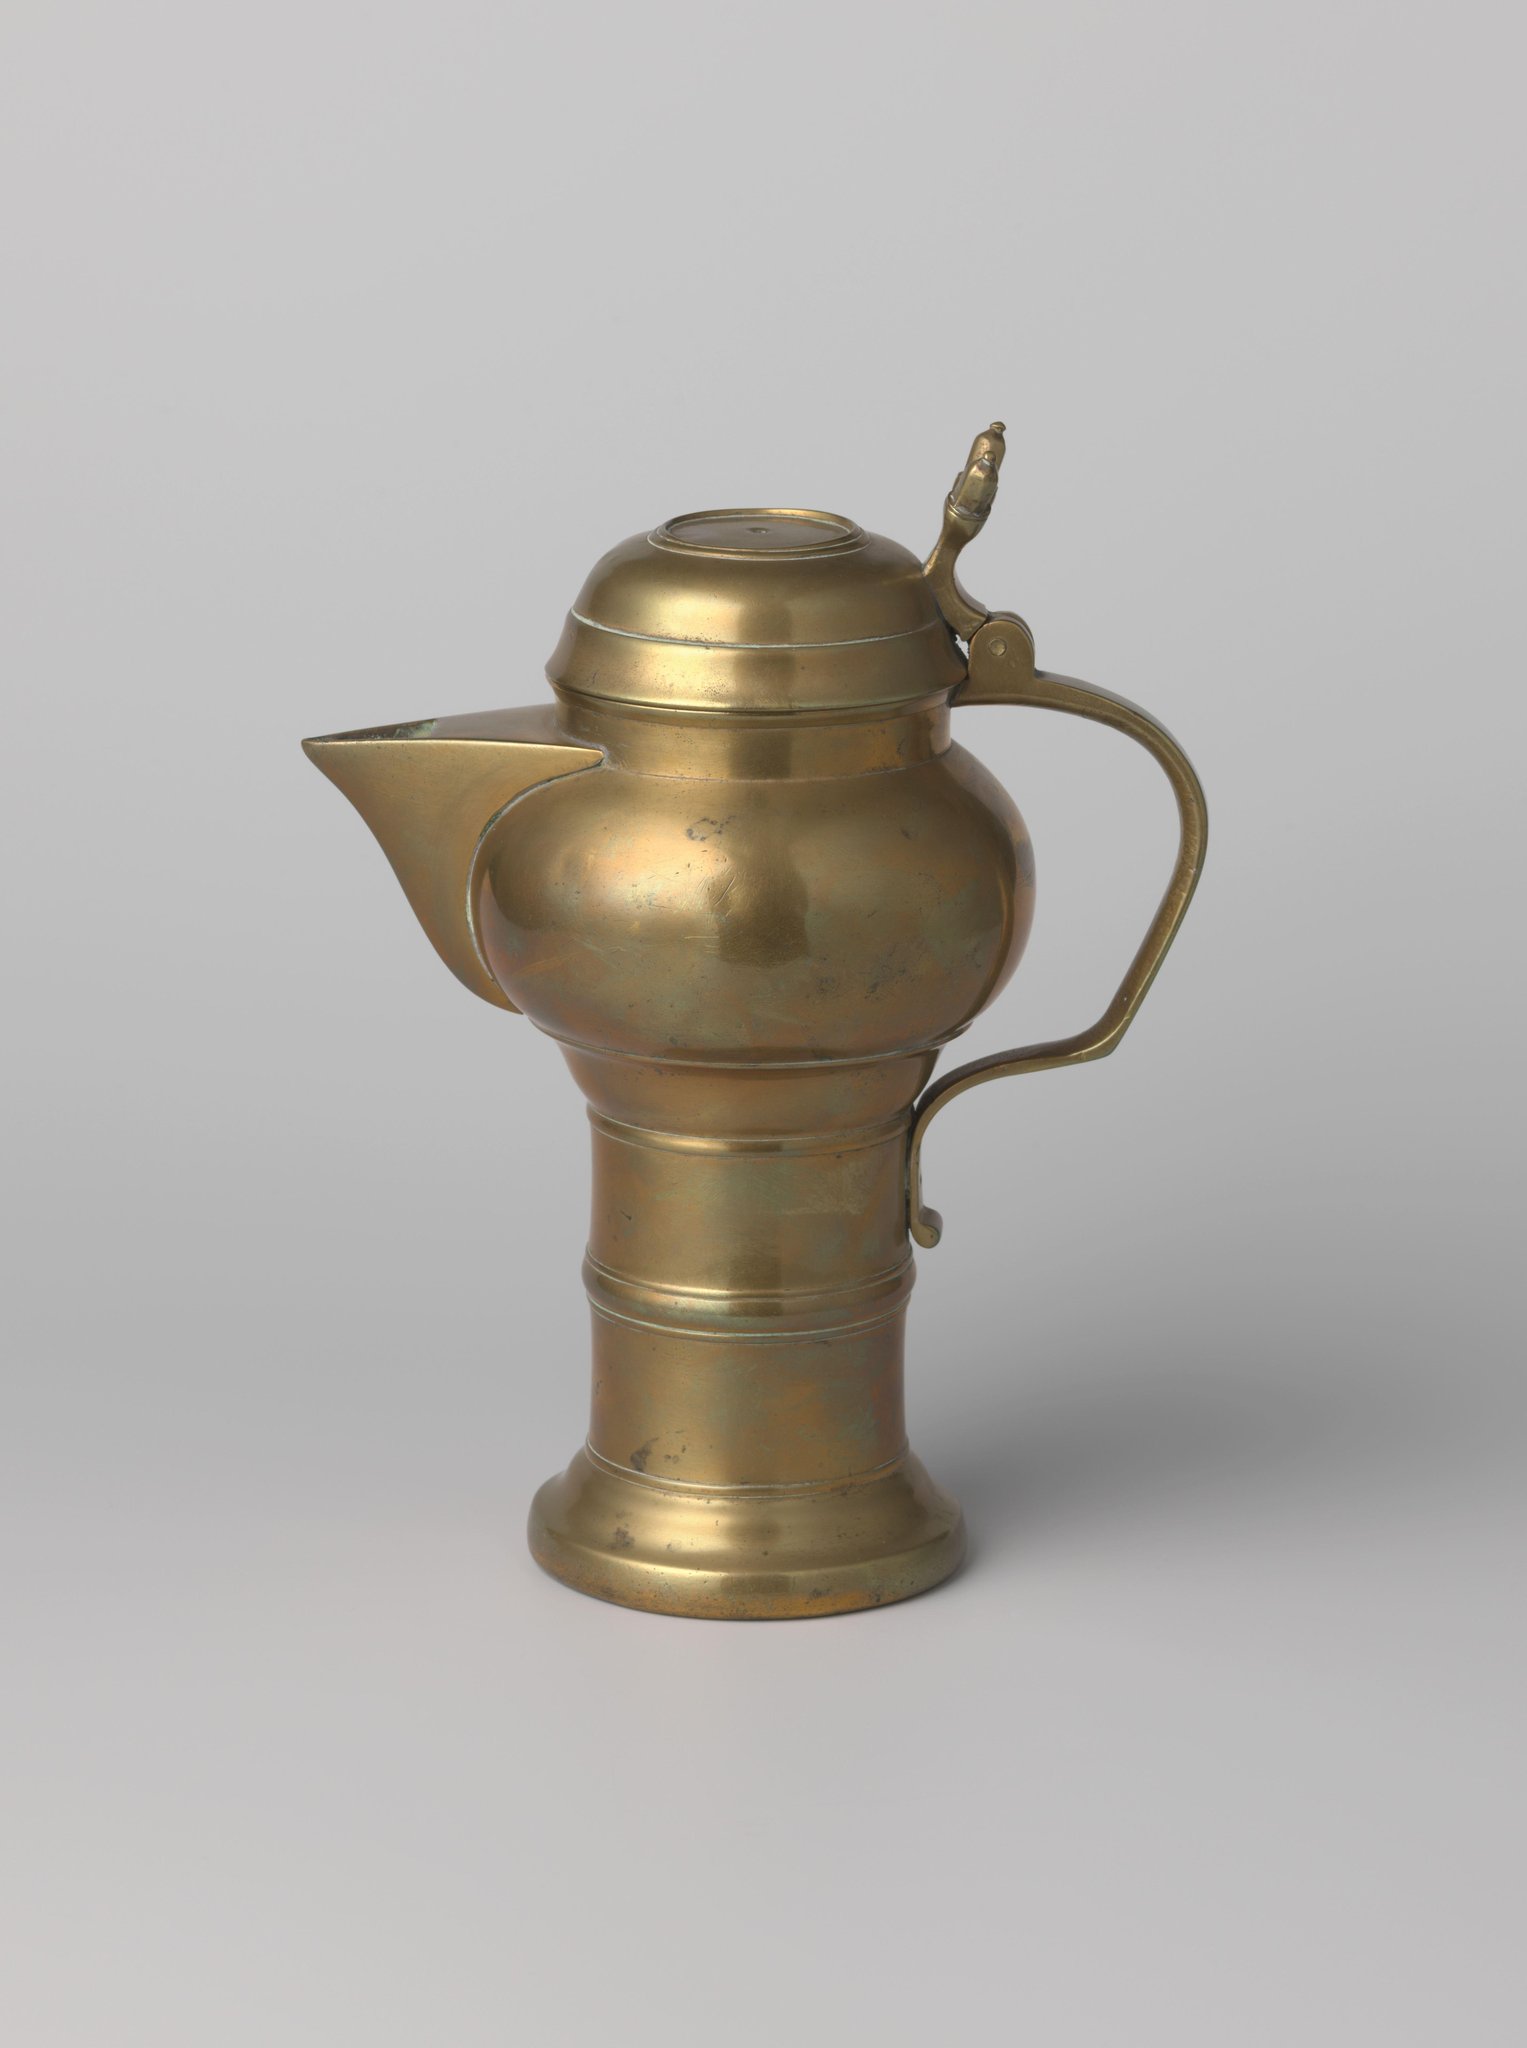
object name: ewer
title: Kan met twee eikels op de duimgreep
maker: Anonymous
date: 1450-1500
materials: brass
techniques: brazing, casting, soldering, turning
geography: nuremberg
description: Jug. Brass. Nüremberg (?), c. 1450 - 1500.